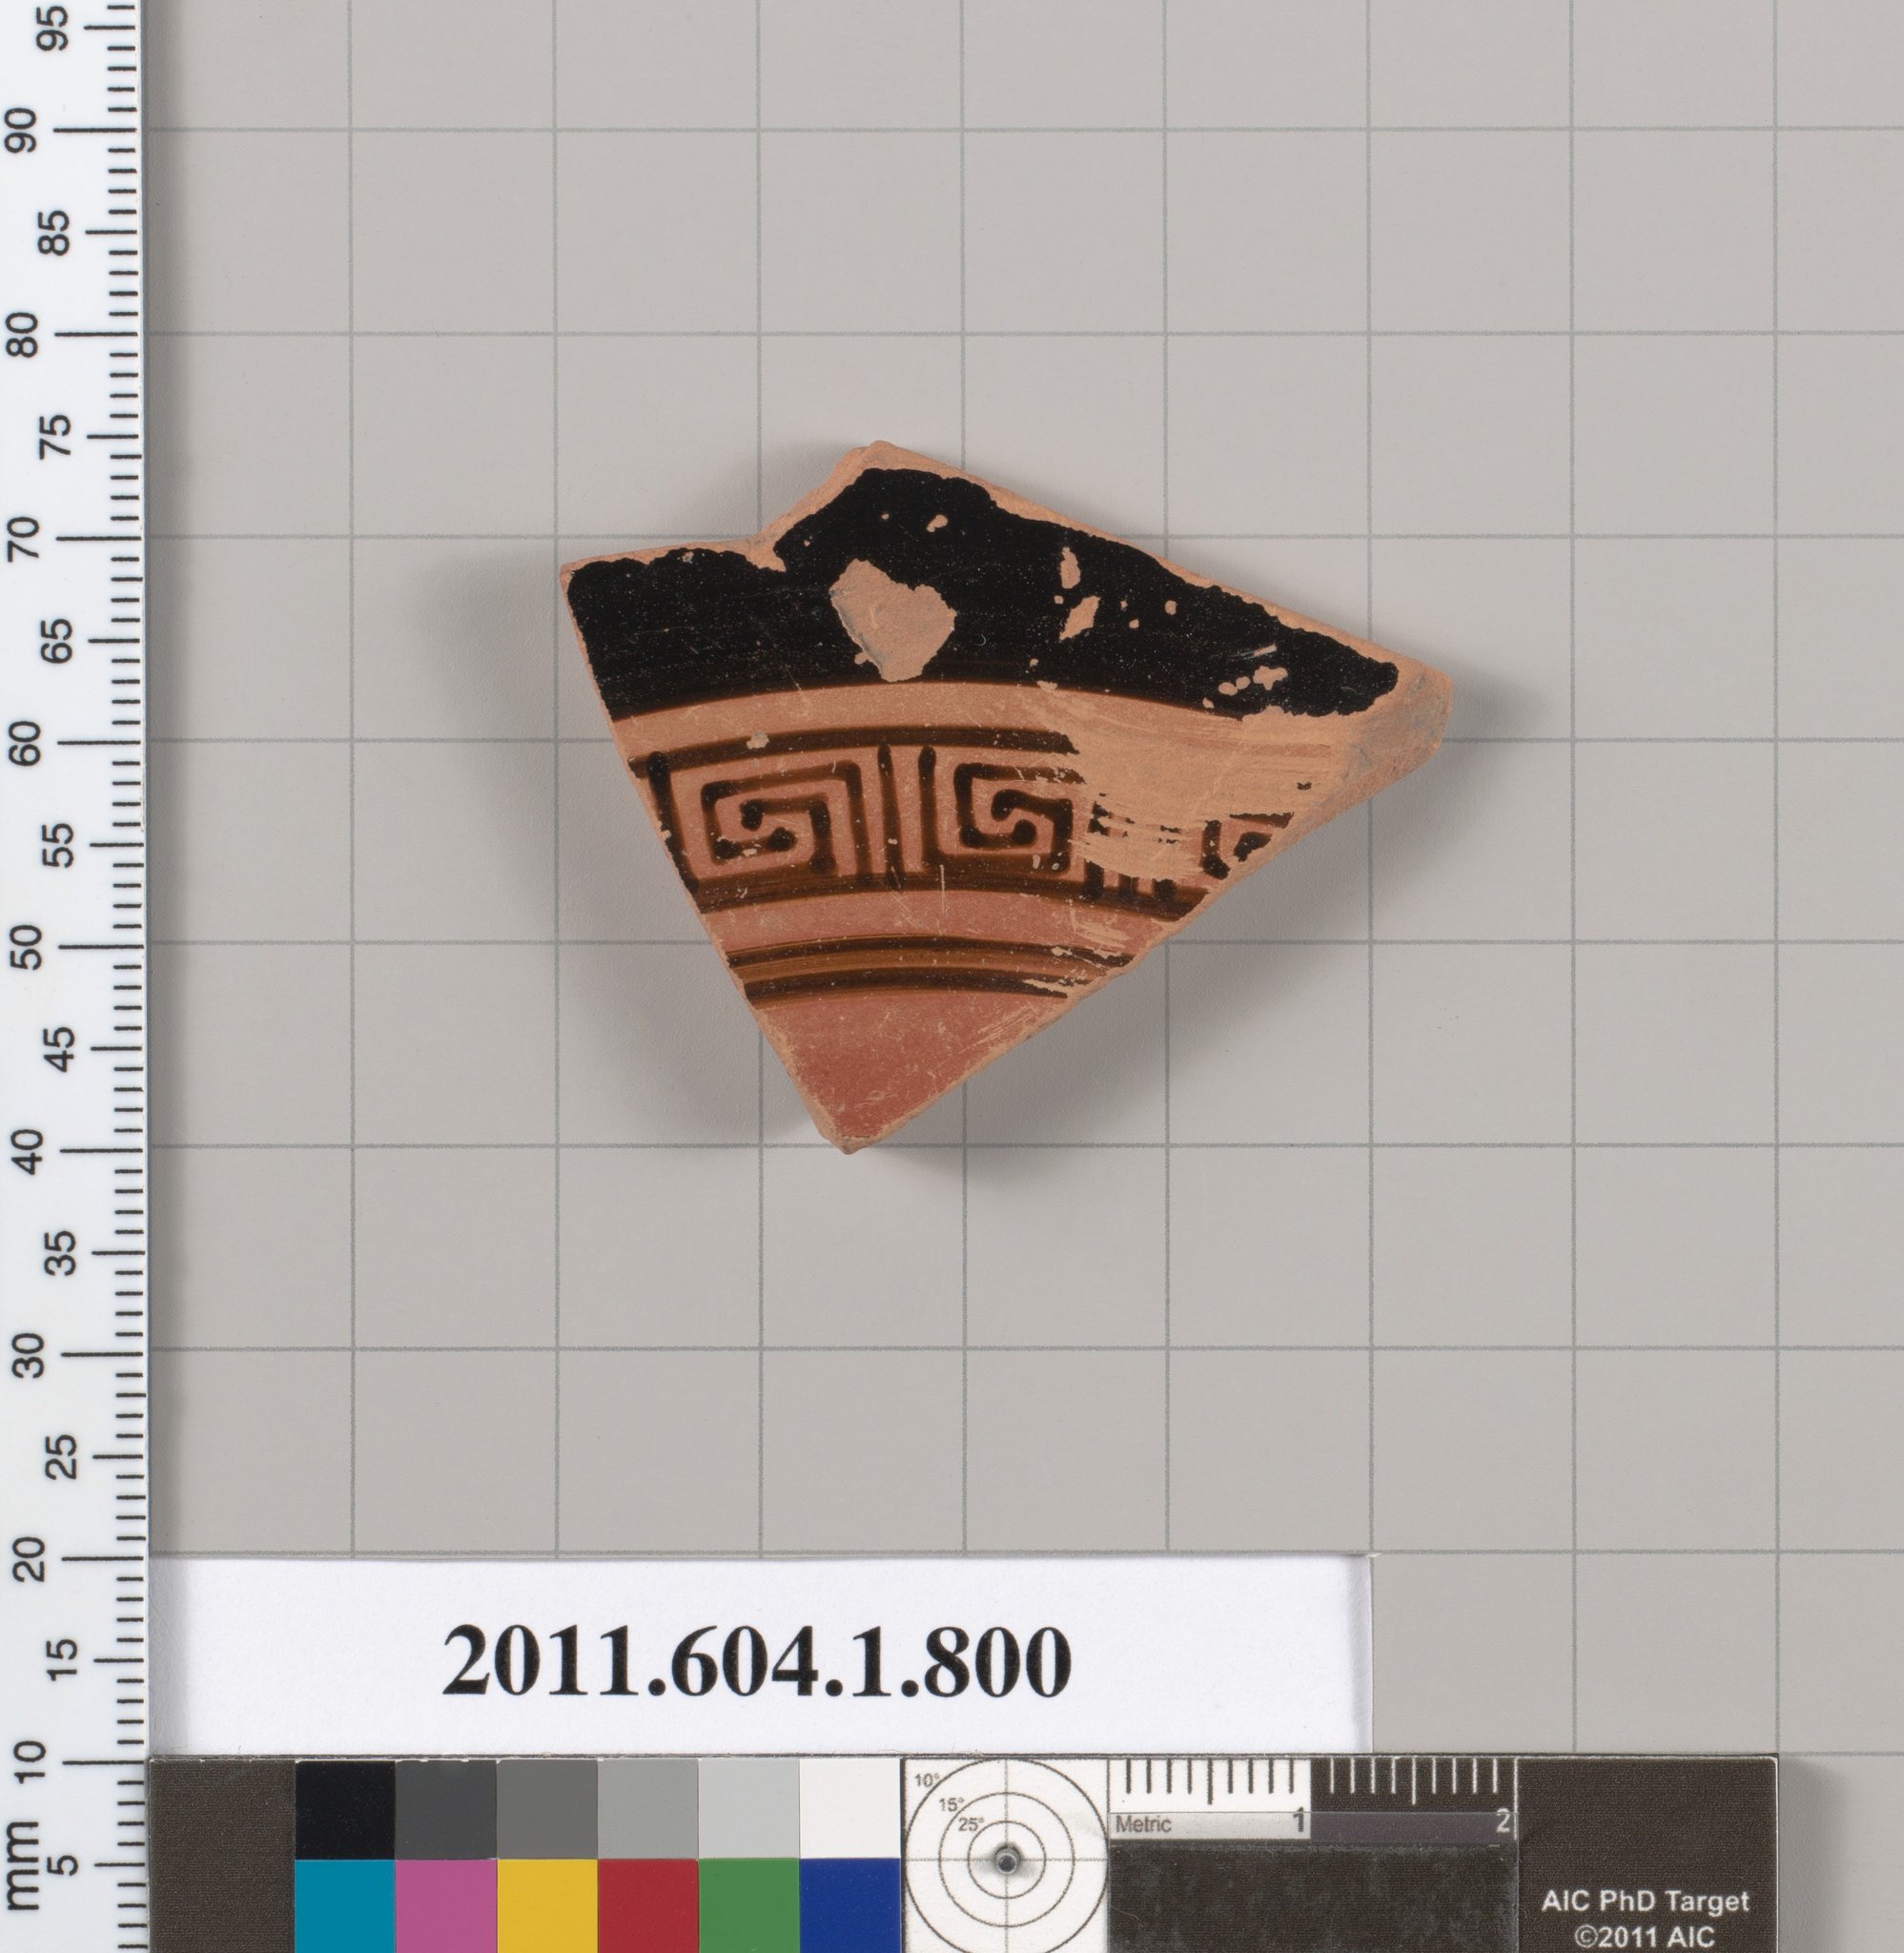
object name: kylix fragment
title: Terracotta fragment of a kylix (drinking cup)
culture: greek, attic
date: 467-435 BCE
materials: terracotta